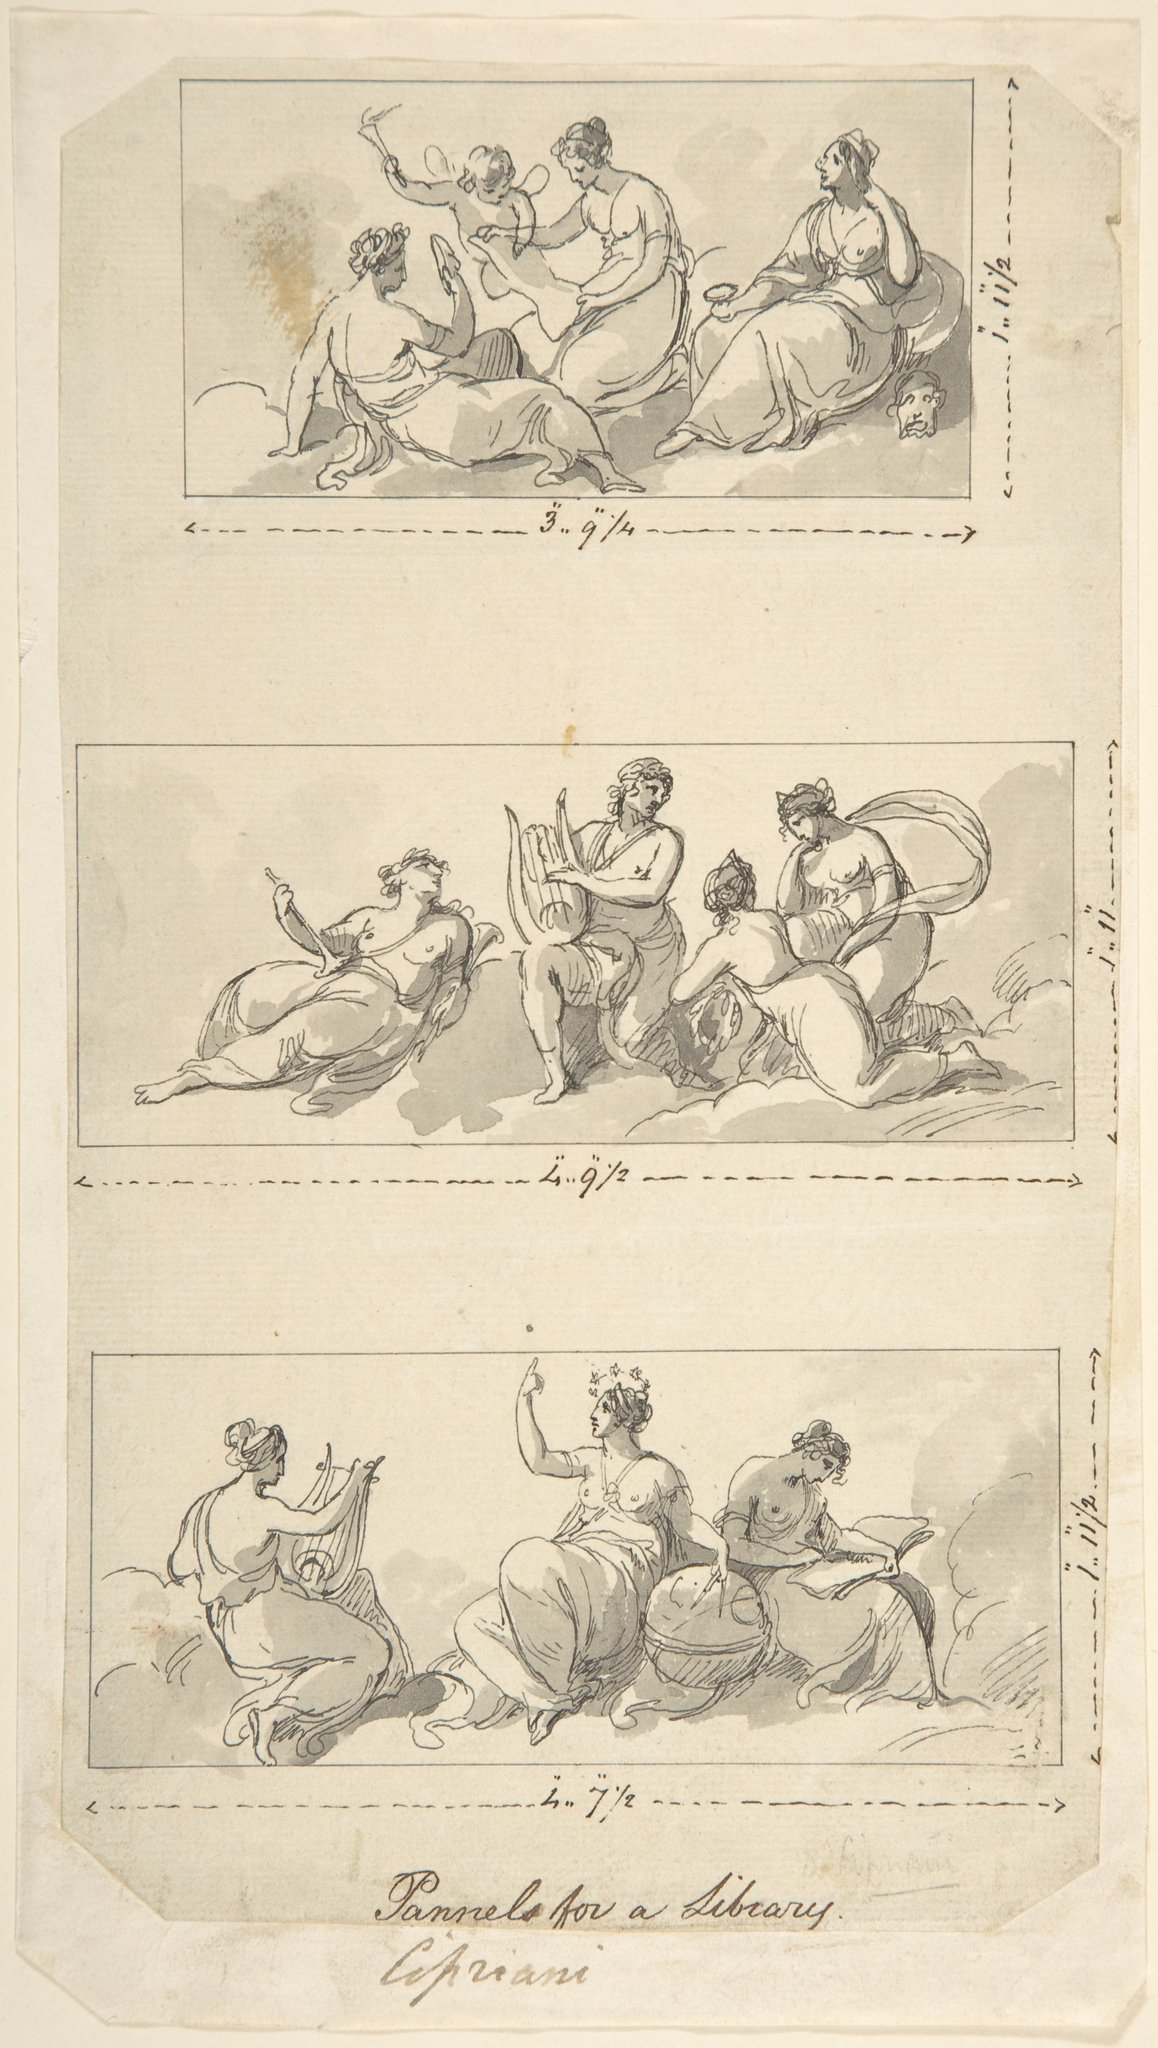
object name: drawing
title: Design for Three Panels for a Library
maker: giovanni battista cipriani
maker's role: artist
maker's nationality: italian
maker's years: 1727-1785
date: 1745-1785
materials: ink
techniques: brush, pen, wash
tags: female nudes